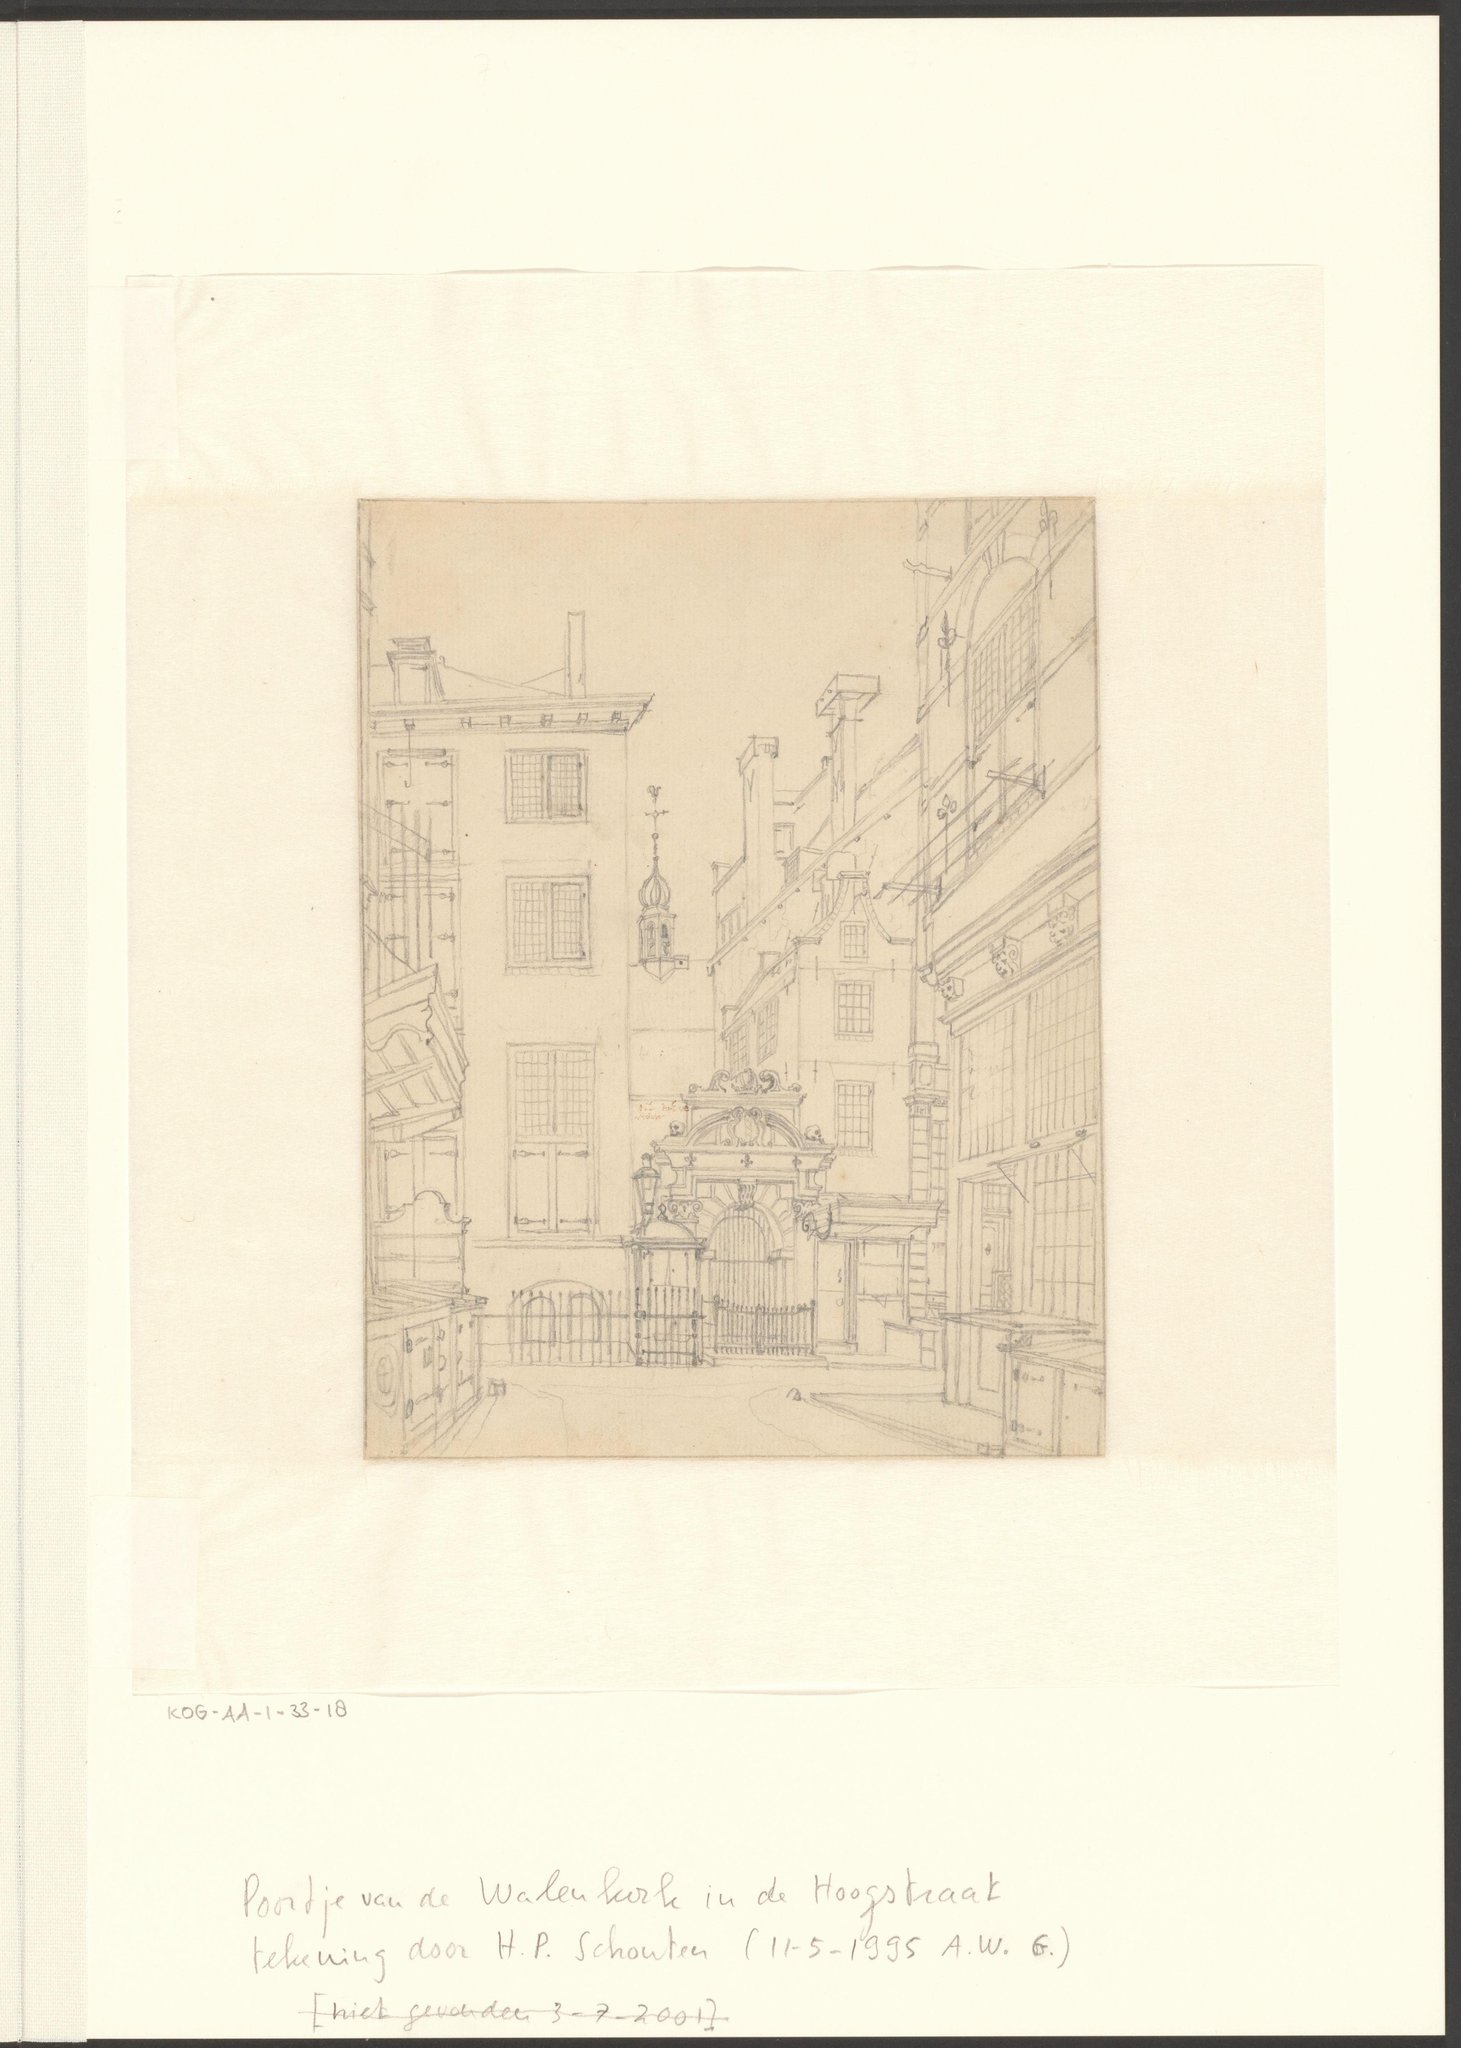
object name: drawing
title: Gezicht op de poort van de Waalse Kerk in de Oude Hoogstraat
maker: hermanus petrus schouten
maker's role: draughtsman, painter, print maker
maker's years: 1747-1822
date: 1757-1822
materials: ink, paper, pencil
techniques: pen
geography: amsterdam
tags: city-view in general; 'veduta', gate, entrance, street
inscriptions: inscription: ‘Poortje van de (...) [niet gevonden 3-7-2001]’, inscription: ‘33-18’, inscription: ‘[...]ijt de [...]straat / op de [...] kerk te zien’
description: Onderwerpsrubriek binnen de Atlas Amsterdam: Waalse gemeente.